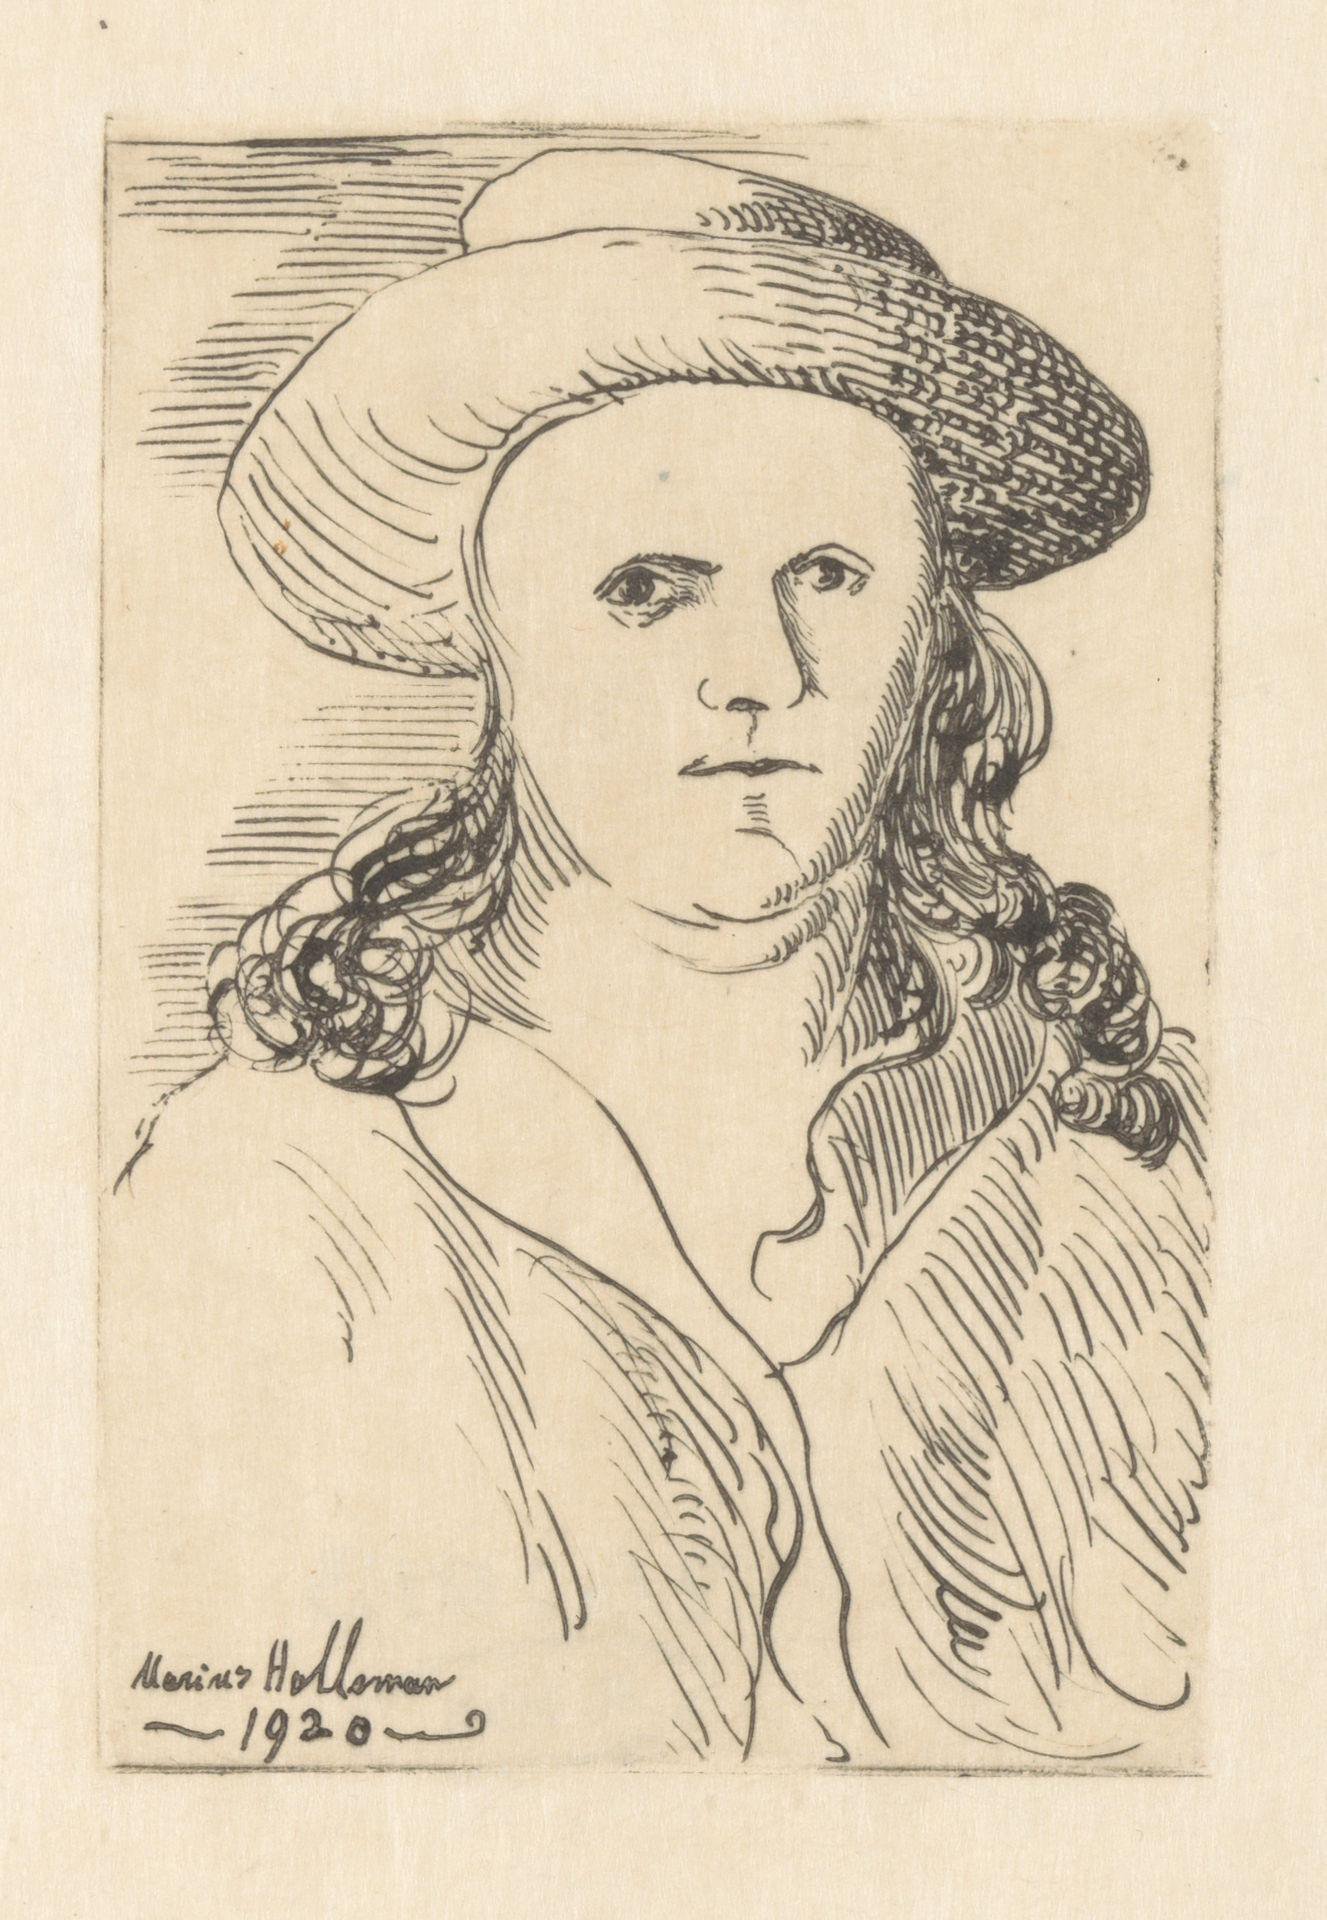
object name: print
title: Man met hoed en lang haar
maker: marius holleman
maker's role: draughtsman, print maker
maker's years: 1878-1926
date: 1920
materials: paper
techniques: etching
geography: groningen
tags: head-gear: hat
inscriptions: collector's mark: Lugt 2228